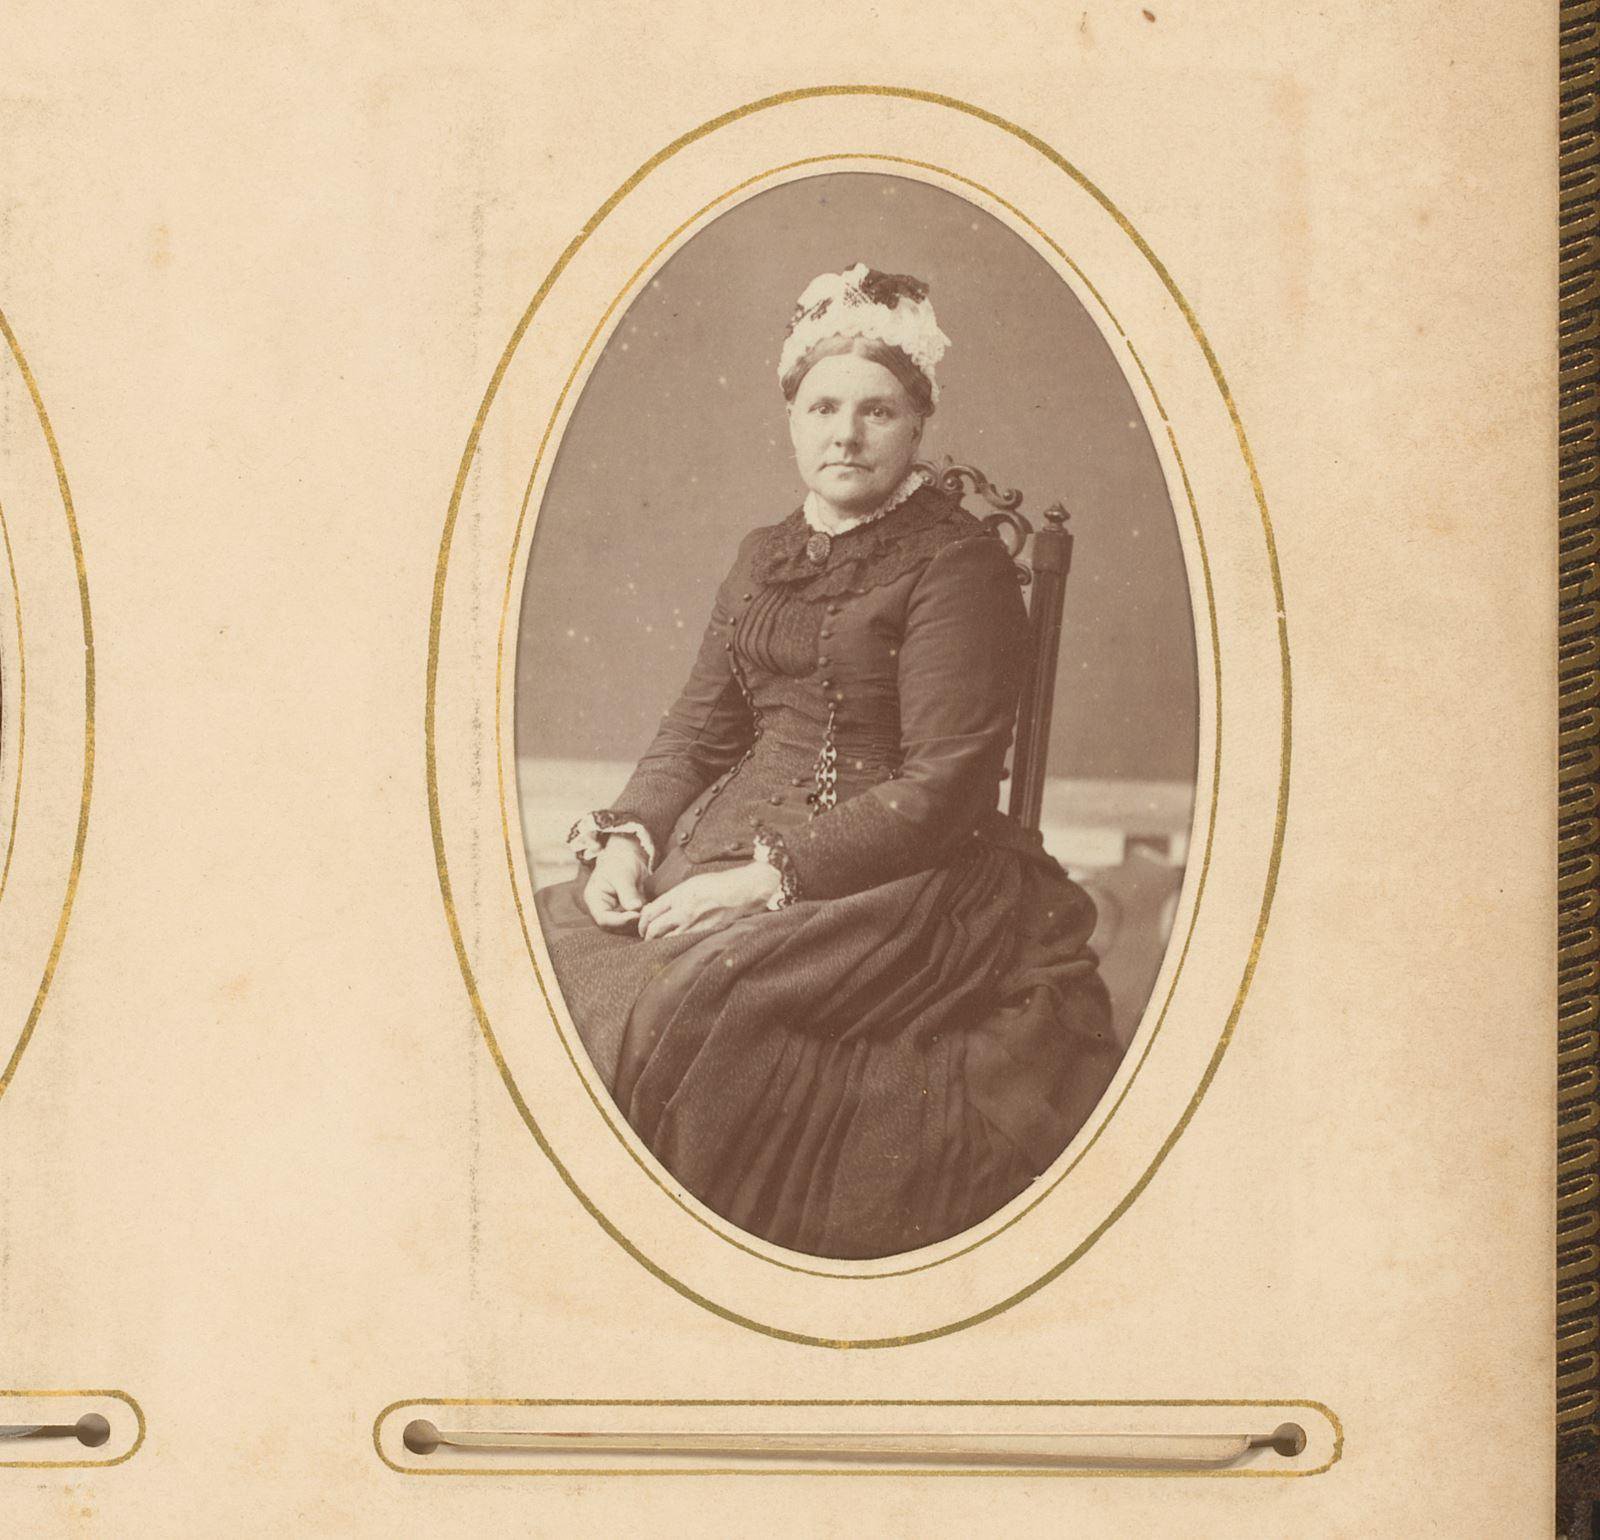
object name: carte de visite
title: Portret van een vrouw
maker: j.c. browne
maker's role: fotograaf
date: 1860-1900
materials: cardboard, photographic support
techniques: albumen print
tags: sitting figure - aa - female human figure, historical persons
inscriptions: inscription: ‘Photographed/ by/ J. Browne/ Successor to Wadle/ 35. Victoria St. West/ (...)’